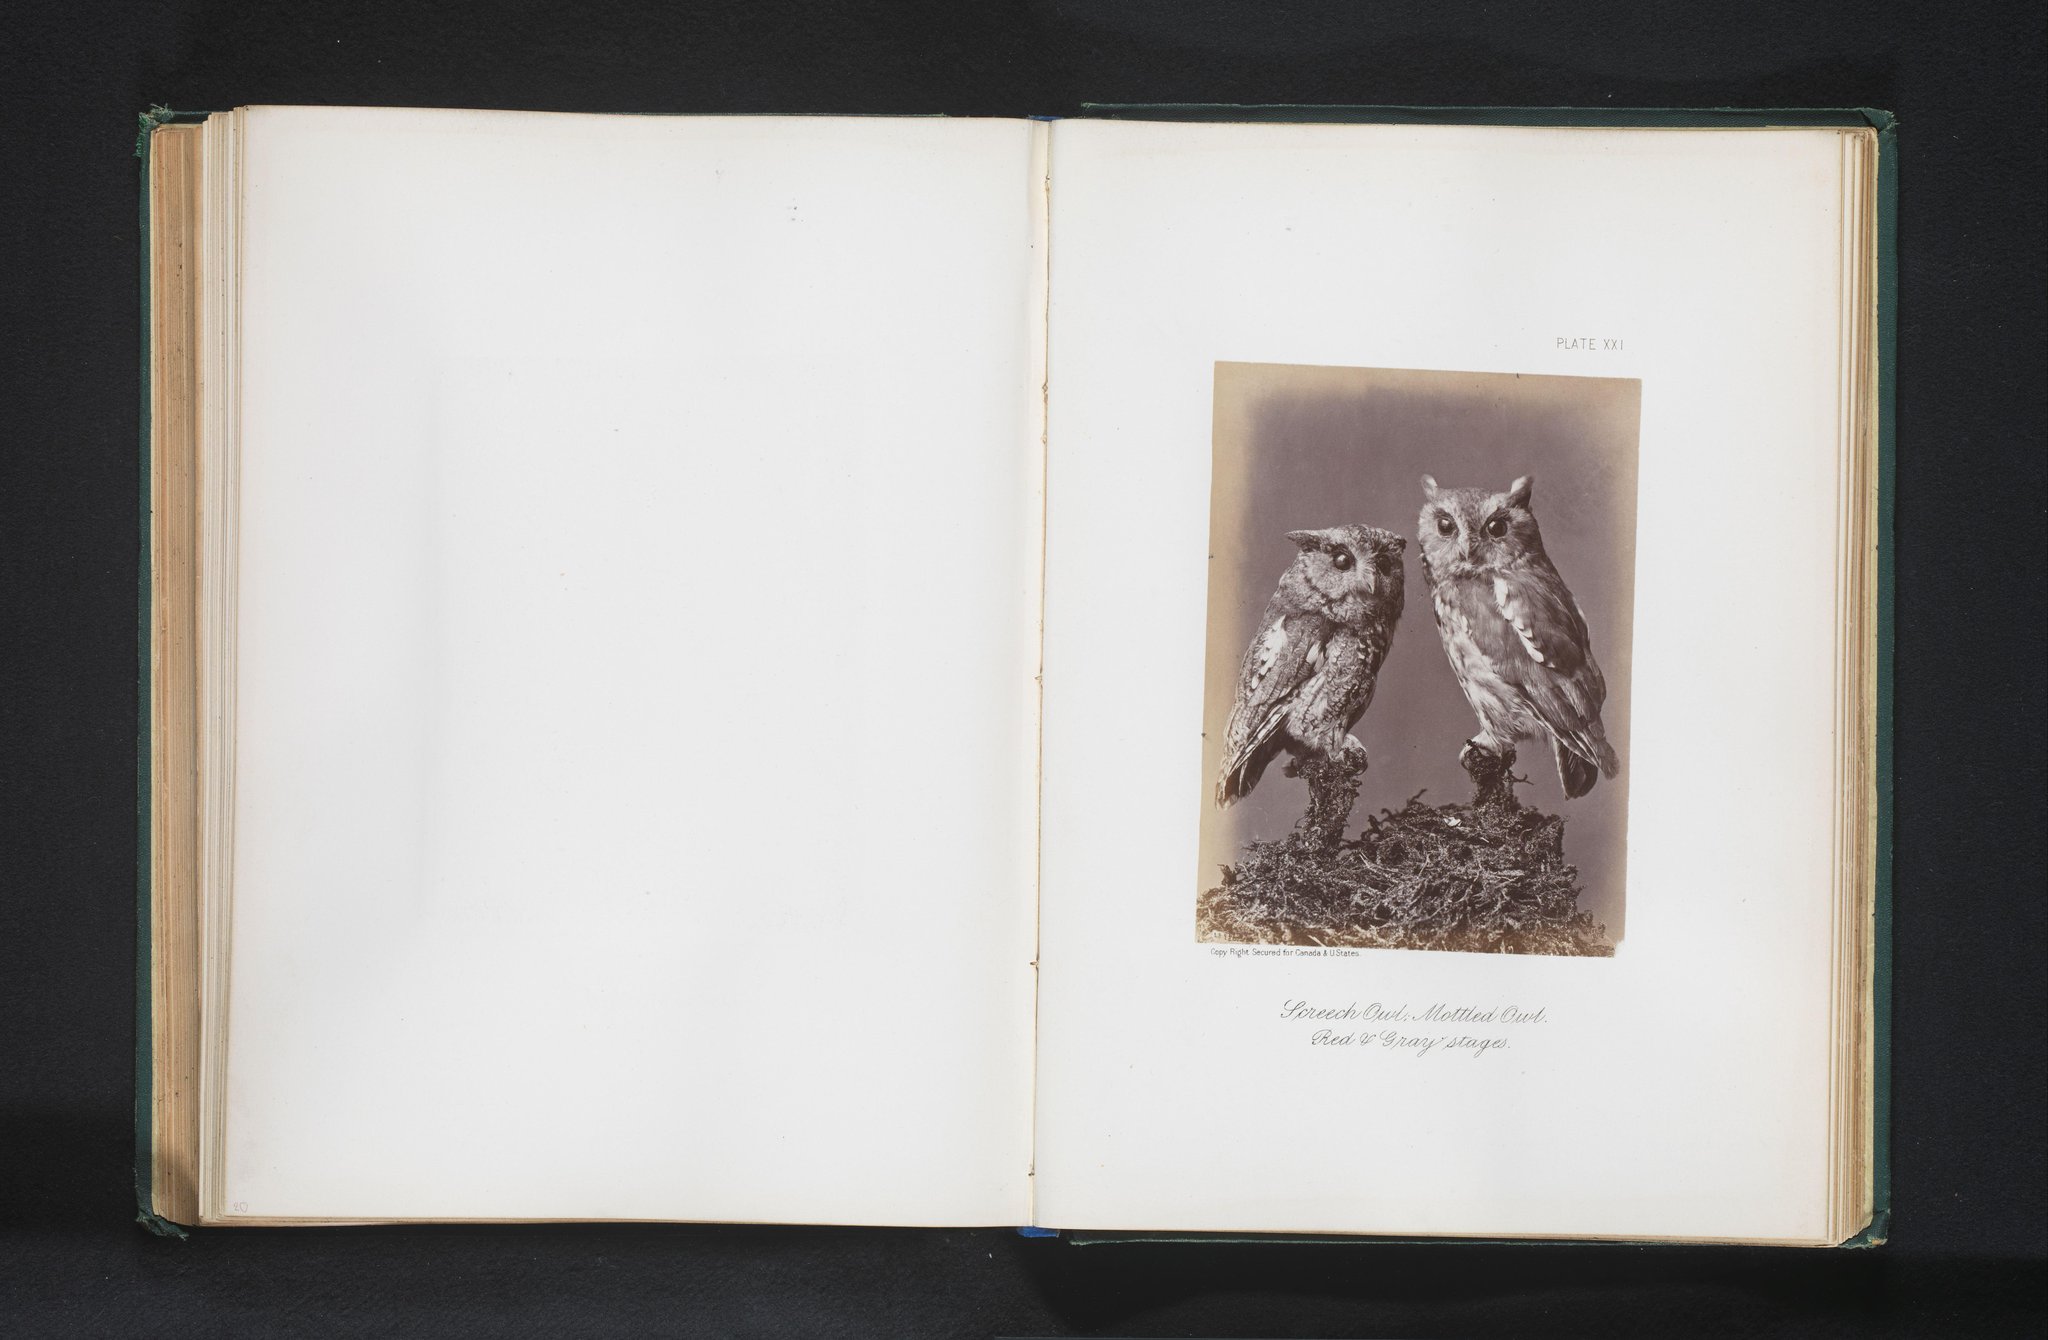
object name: page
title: Screech Owl; Mottled Owl. Red & gray stages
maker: william notman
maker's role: fotograaf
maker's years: 1826-1891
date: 1871-1876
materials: paper, photographic support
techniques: albumen print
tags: collection of animals, owls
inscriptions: inscription: ‘Copy Right Secured for Canada & U.States’, number: ‘PLATE XXI’